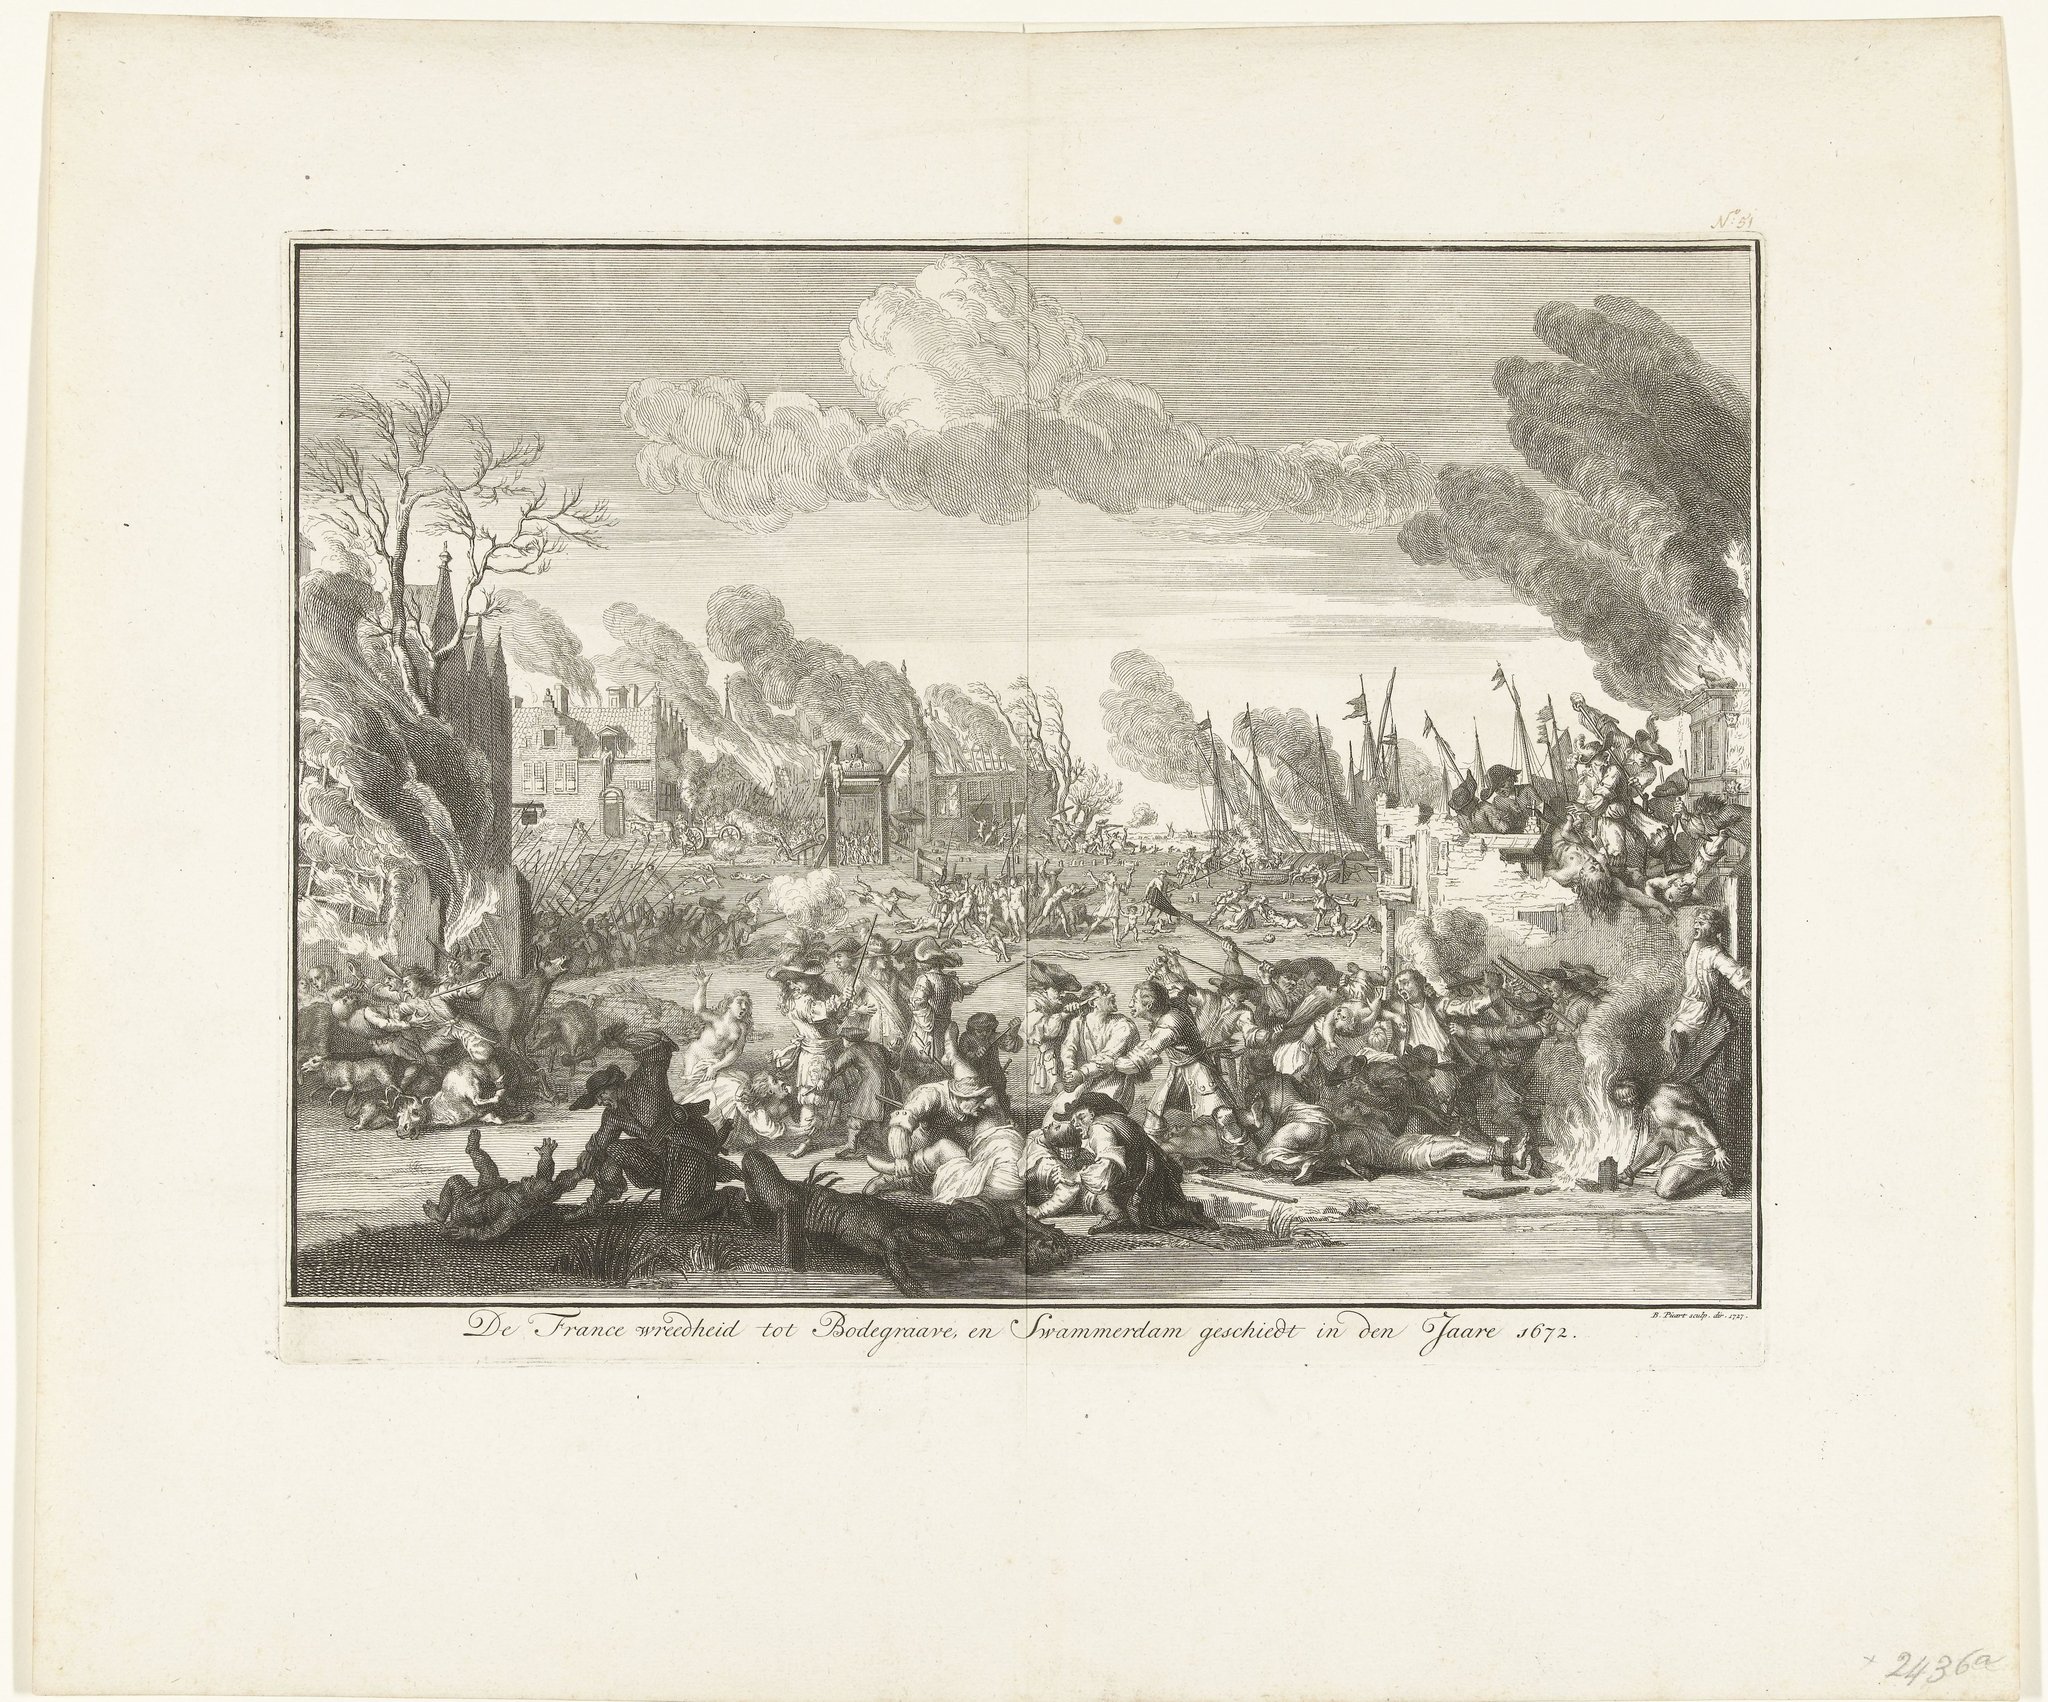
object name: history print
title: Franse wreedheden in Bodegraven en Zwammerdam, 1672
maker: bernard picart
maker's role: draughtsman, print maker, publisher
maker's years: 1673-1733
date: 1727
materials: paper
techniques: engraving, etching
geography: northern netherlands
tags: rape, violation, plundering ~ soldiers, violent death, being killed; being mishandled and maltreated; seeking death, massacre ~ war, bodegraven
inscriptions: inscription: ‘No: 51’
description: De plaat eerst uitgegeven als illustratie in: J. le Clerc, Histoire des Provinces-Unies des Pays-Bas, Amsterdam 1723-1728, 4 delen. Hierna ook gebruikt als illustratie de Nederlandse uitgave: J. le Clerc, Geschiedenissen der Vereenigde Nederlanden, sedert den aanvang van die Republyk tot op den Vrede van Utrecht in 't jaar 1713 en het Tractaat van Barriere in 't jaar 1715 gesloten, Z. Chatelain, Amsterdam 1730, 3 delen. Kopie naar de prent van Romeyn de Hooghe (FMH 2435).